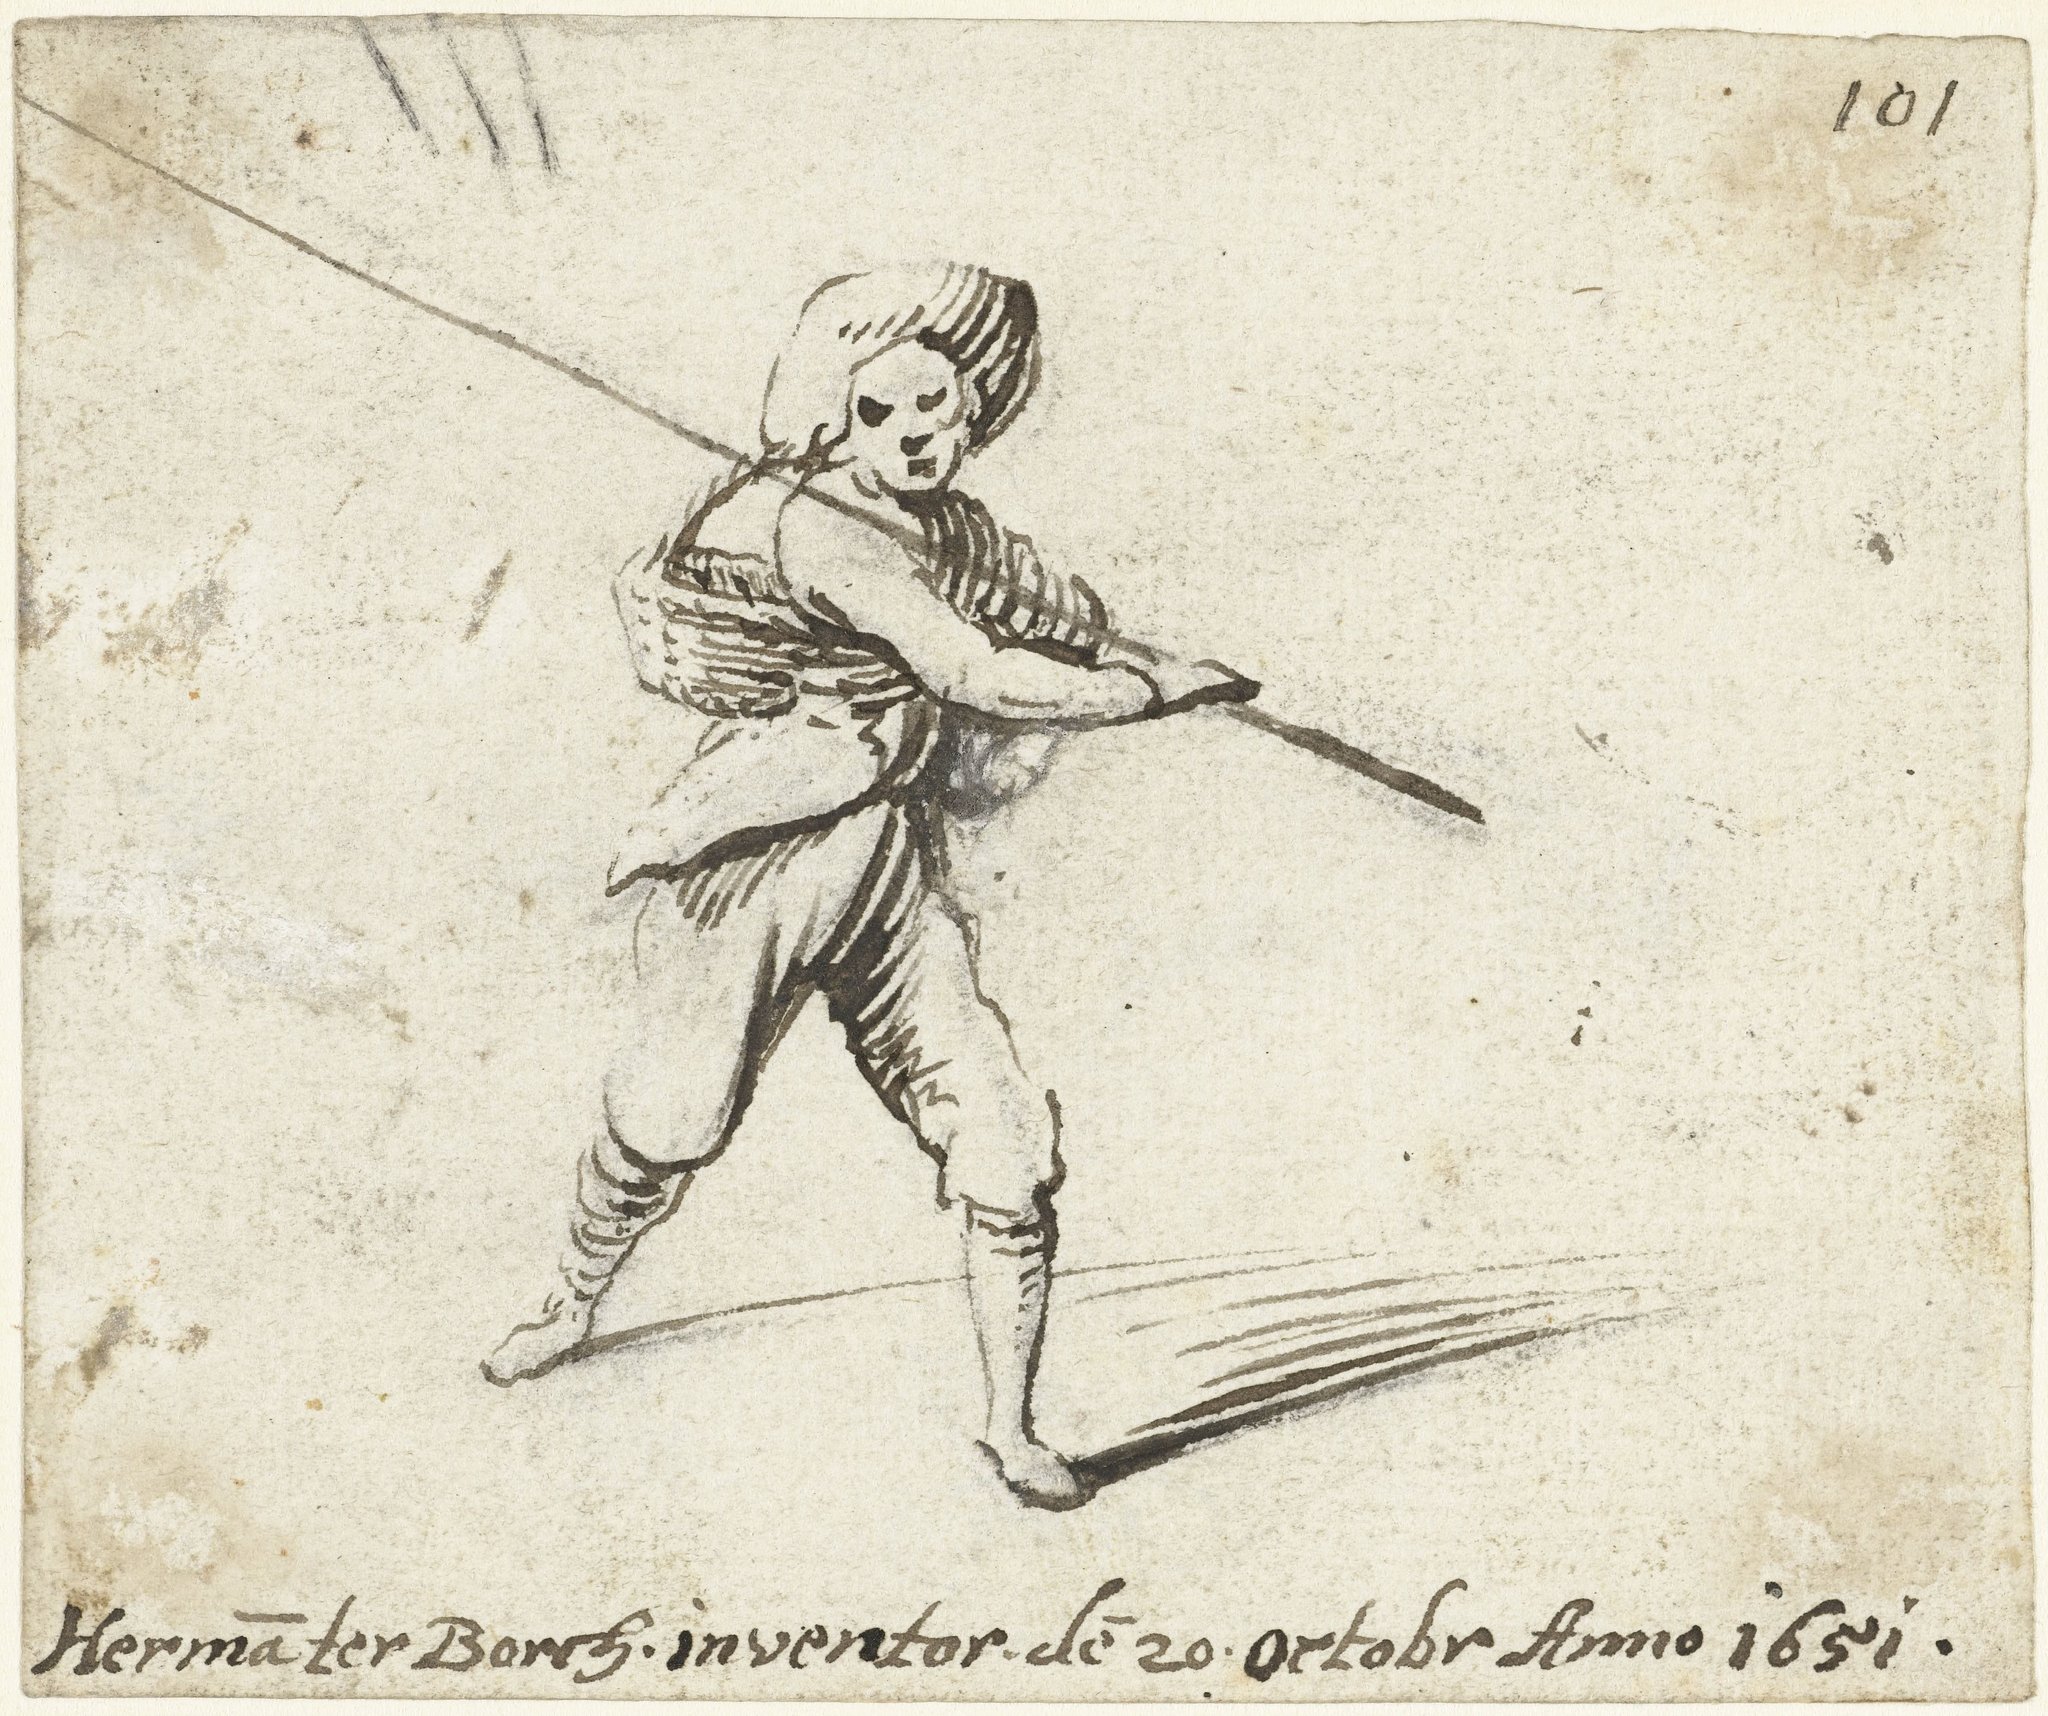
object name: drawing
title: Jongen die een mand en een paal draagt, naar rechts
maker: harmen ter borch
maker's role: draughtsman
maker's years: 1638-1677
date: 1651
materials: chalk, ink, paper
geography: zwolle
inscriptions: annotation: ‘Herma[n] ter Borch. inventor. de[n] 20.octobr Anno 1651’